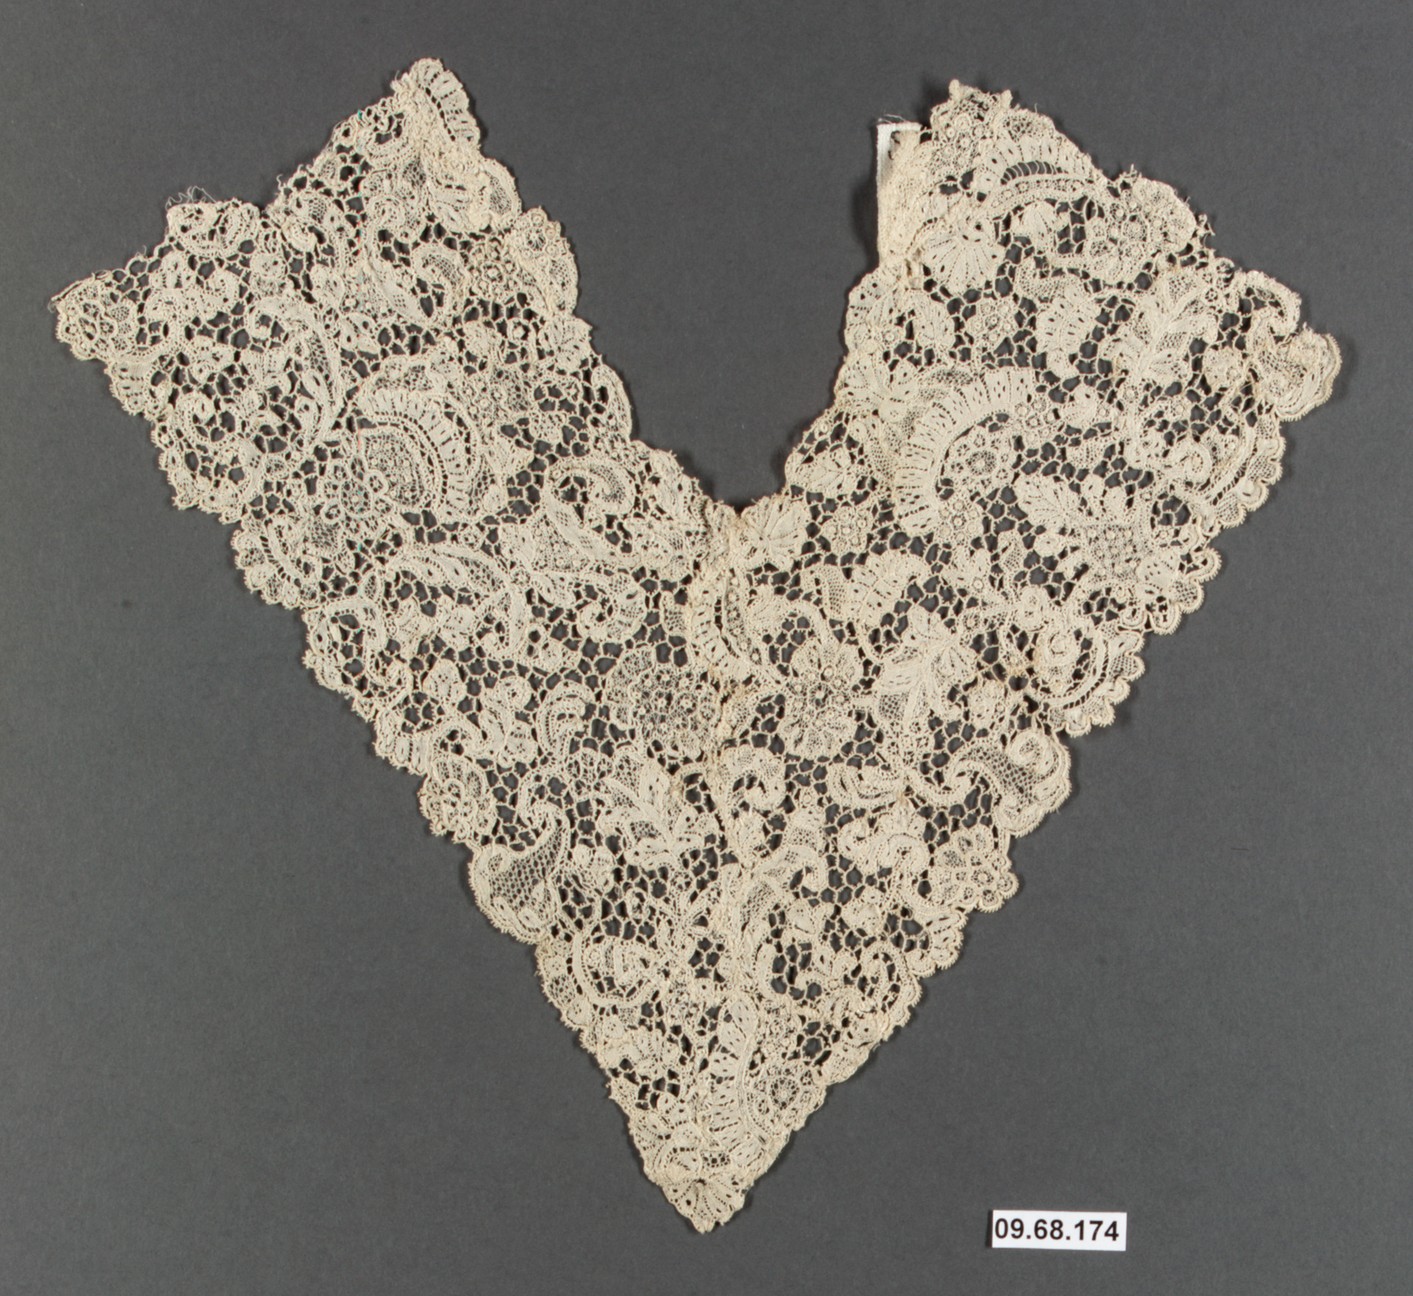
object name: corner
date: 1701-1800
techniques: lace